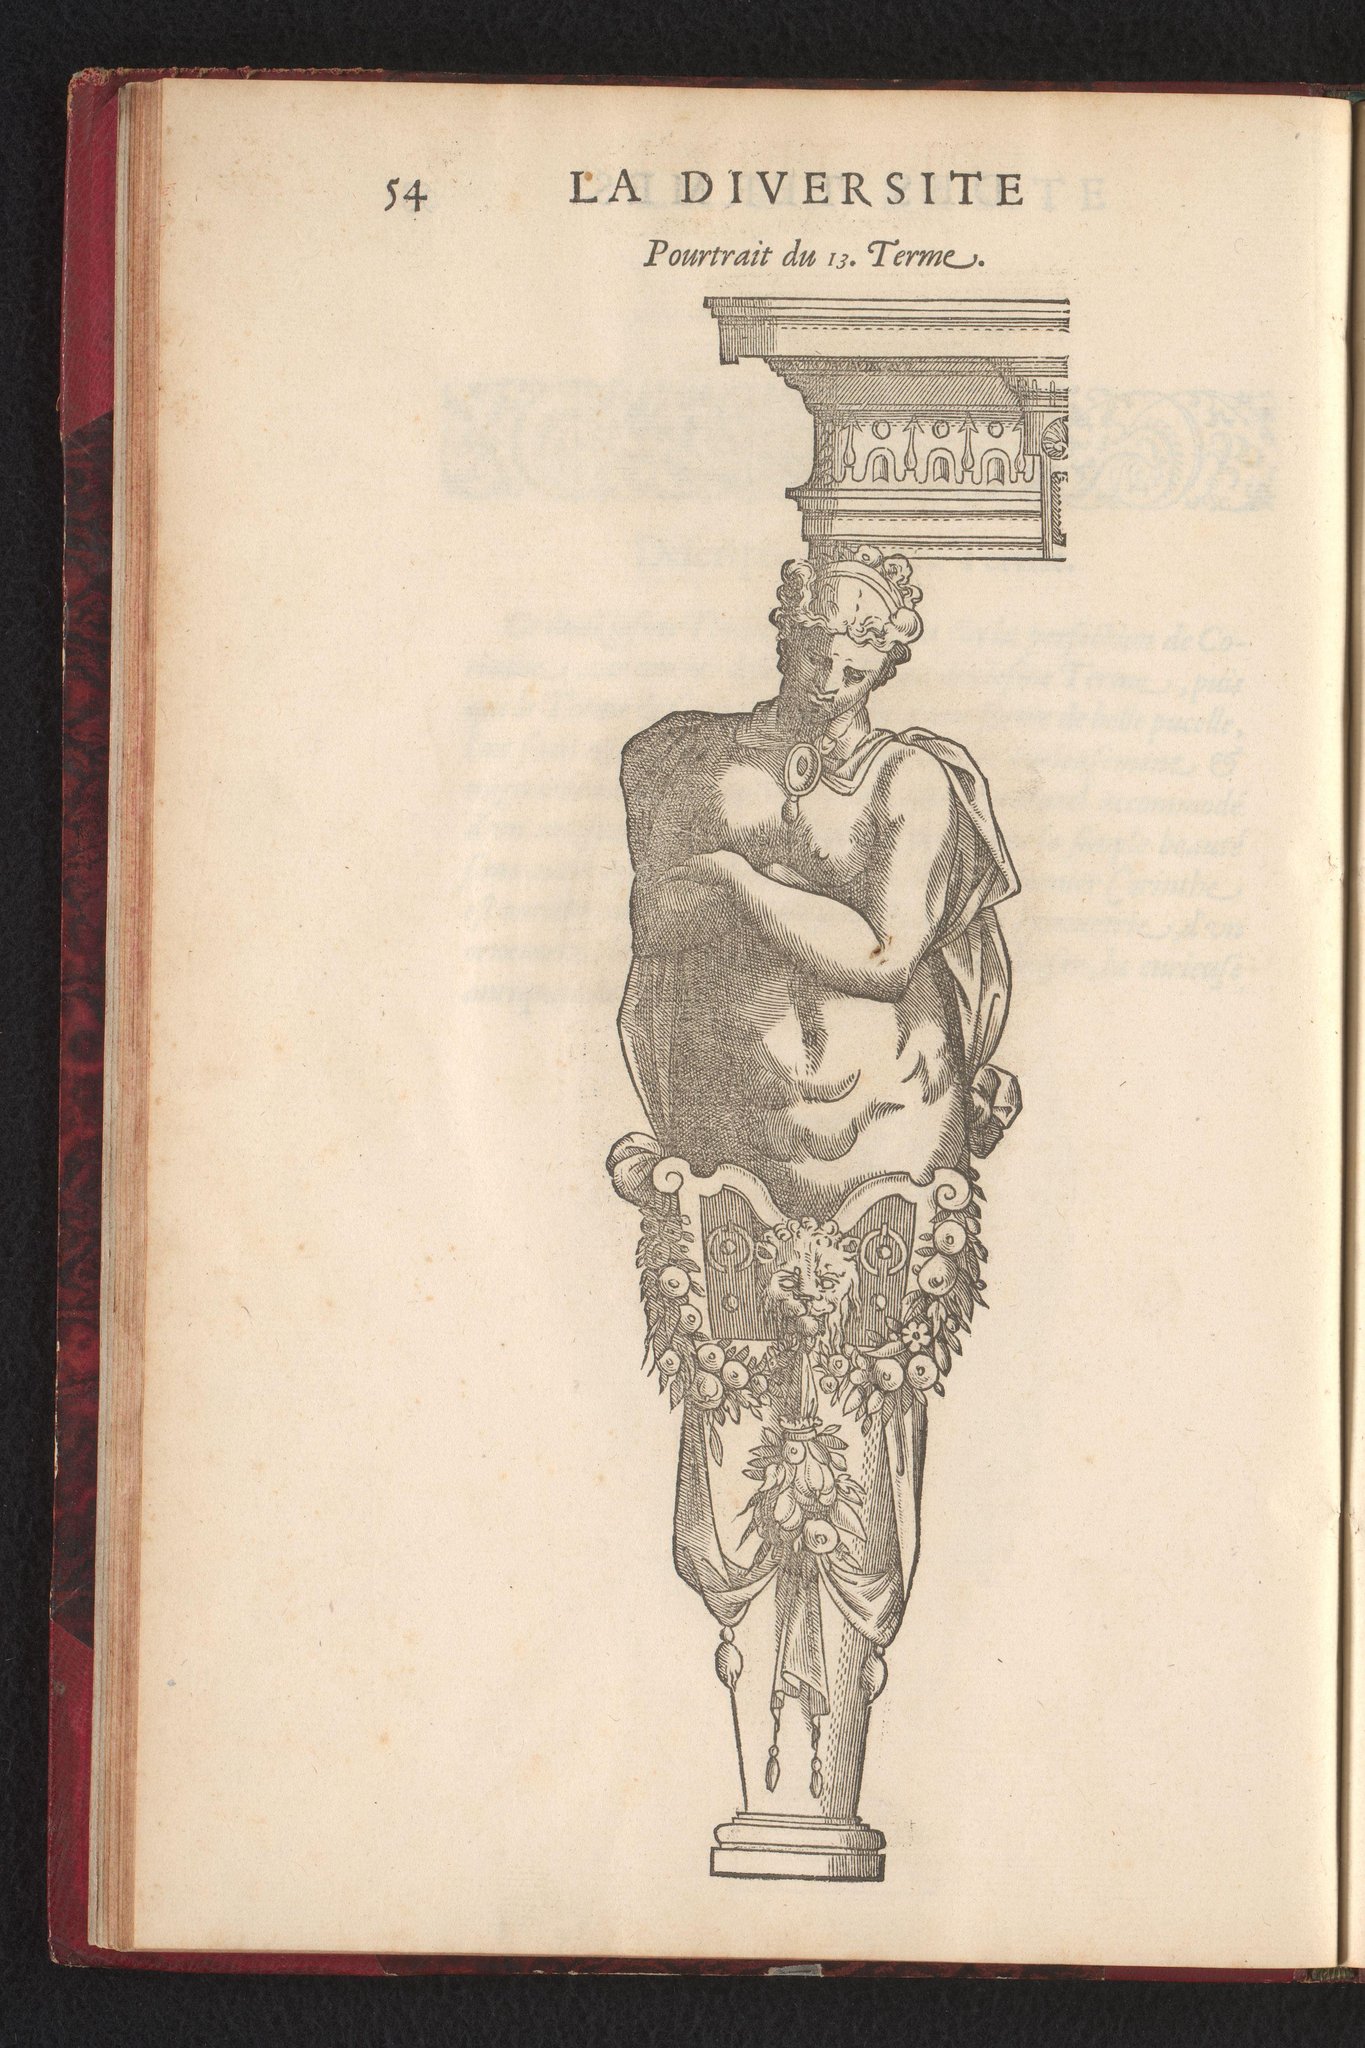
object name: print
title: Oeuvre de la diversité des termes, dont on use en architecture, reduict en ordre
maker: Anonymous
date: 1572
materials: paper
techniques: letterpress printing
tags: herms (garden ornaments), pedestal of a piece of sculpture (perhaps in the form of a herm), herm: pillar with the head of mercury, patron of travellers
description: Linksboven genummerd: 54. Volgens de toelichting op pagina 56 gaat het hier om de Composiete orde. Prent maakt deel uit van een album.